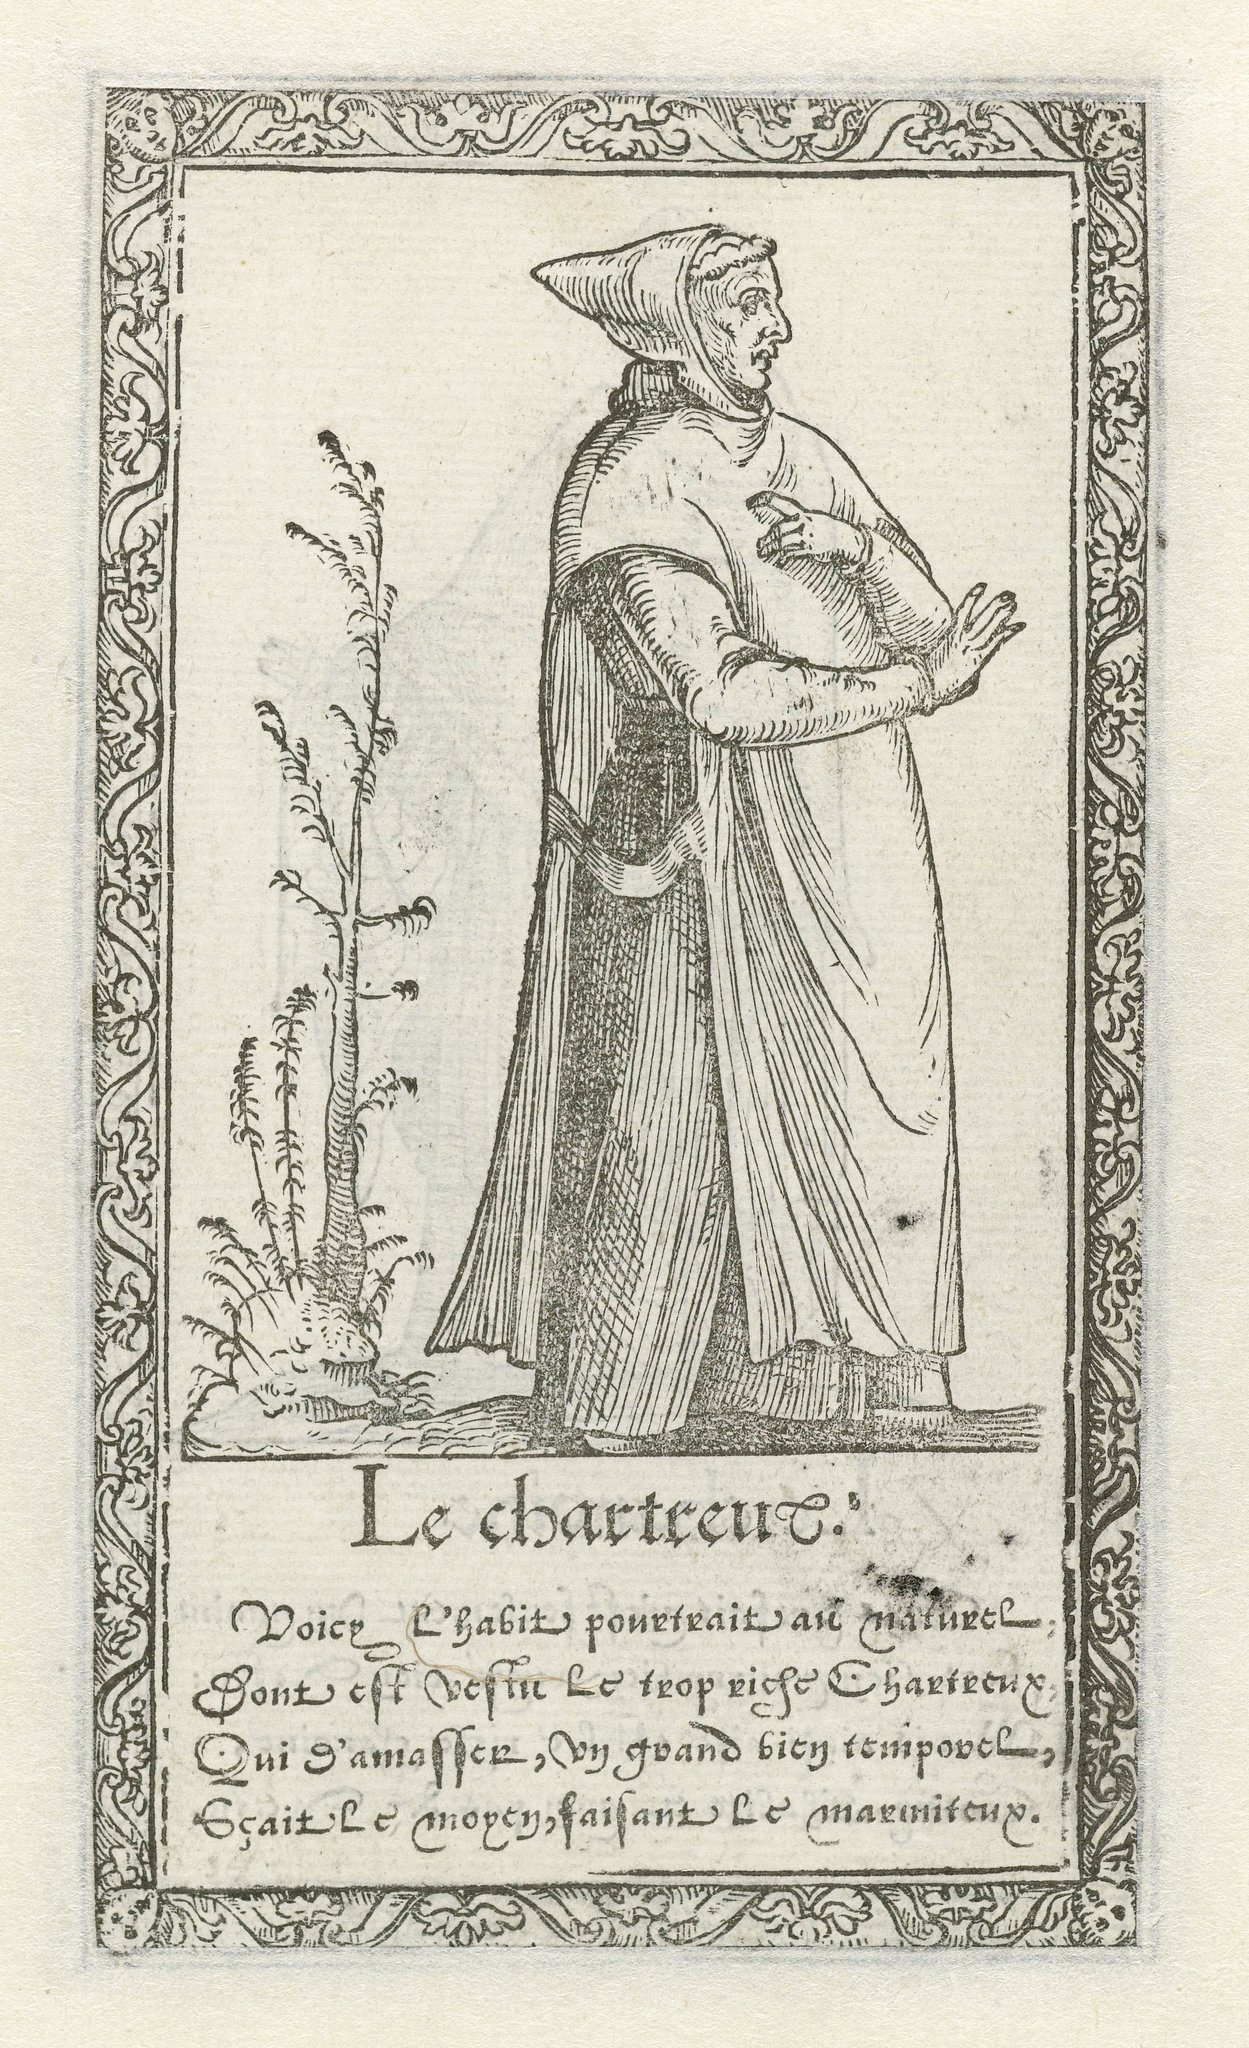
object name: print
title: Serie van verschillende klederdrachten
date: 1562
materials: paper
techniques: woodcut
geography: paris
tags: monastic orders, monastic life: carthusians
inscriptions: collector's mark: Lugt 2228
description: Dit is prent 41 uit een serie van 121. Binnen deze serie zijn er prenten gemaakt naar voorbeelden van Jean-François de Roberval en Enea Vico, onbekend welke precies.